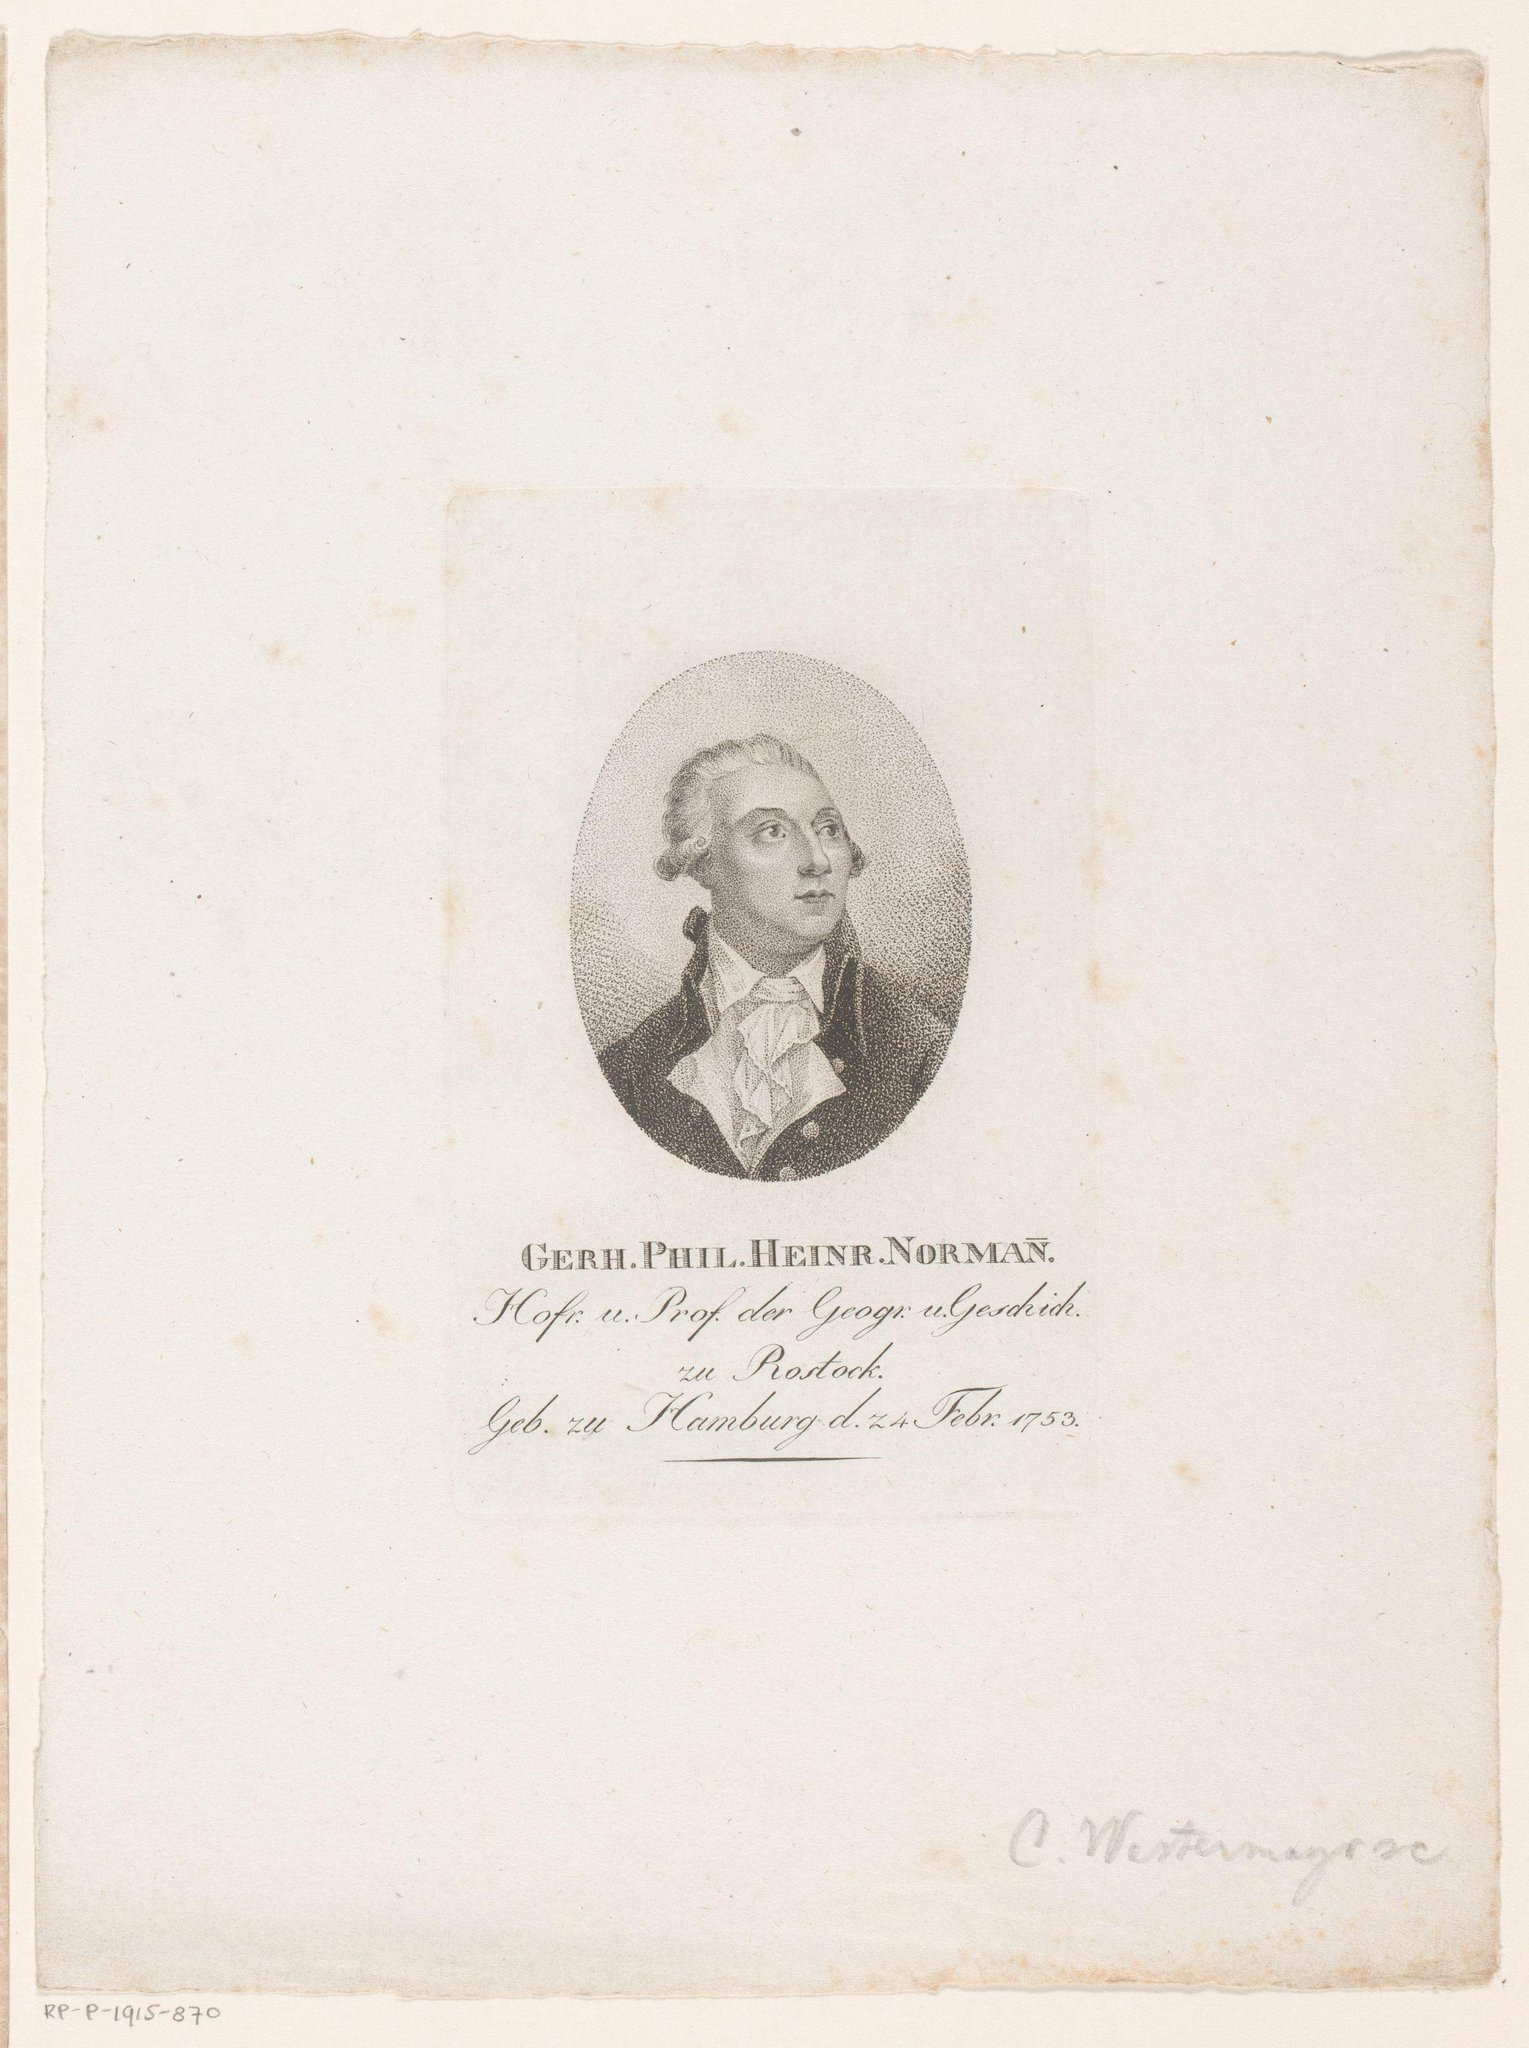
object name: print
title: Portret van Gerhard Philipp Heinrich Norrmann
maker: konrad westermayr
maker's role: print maker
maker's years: 1765-1834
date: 1775-1834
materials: paper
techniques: engraving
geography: germany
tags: historical persons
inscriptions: collector's mark: Lugt 2228